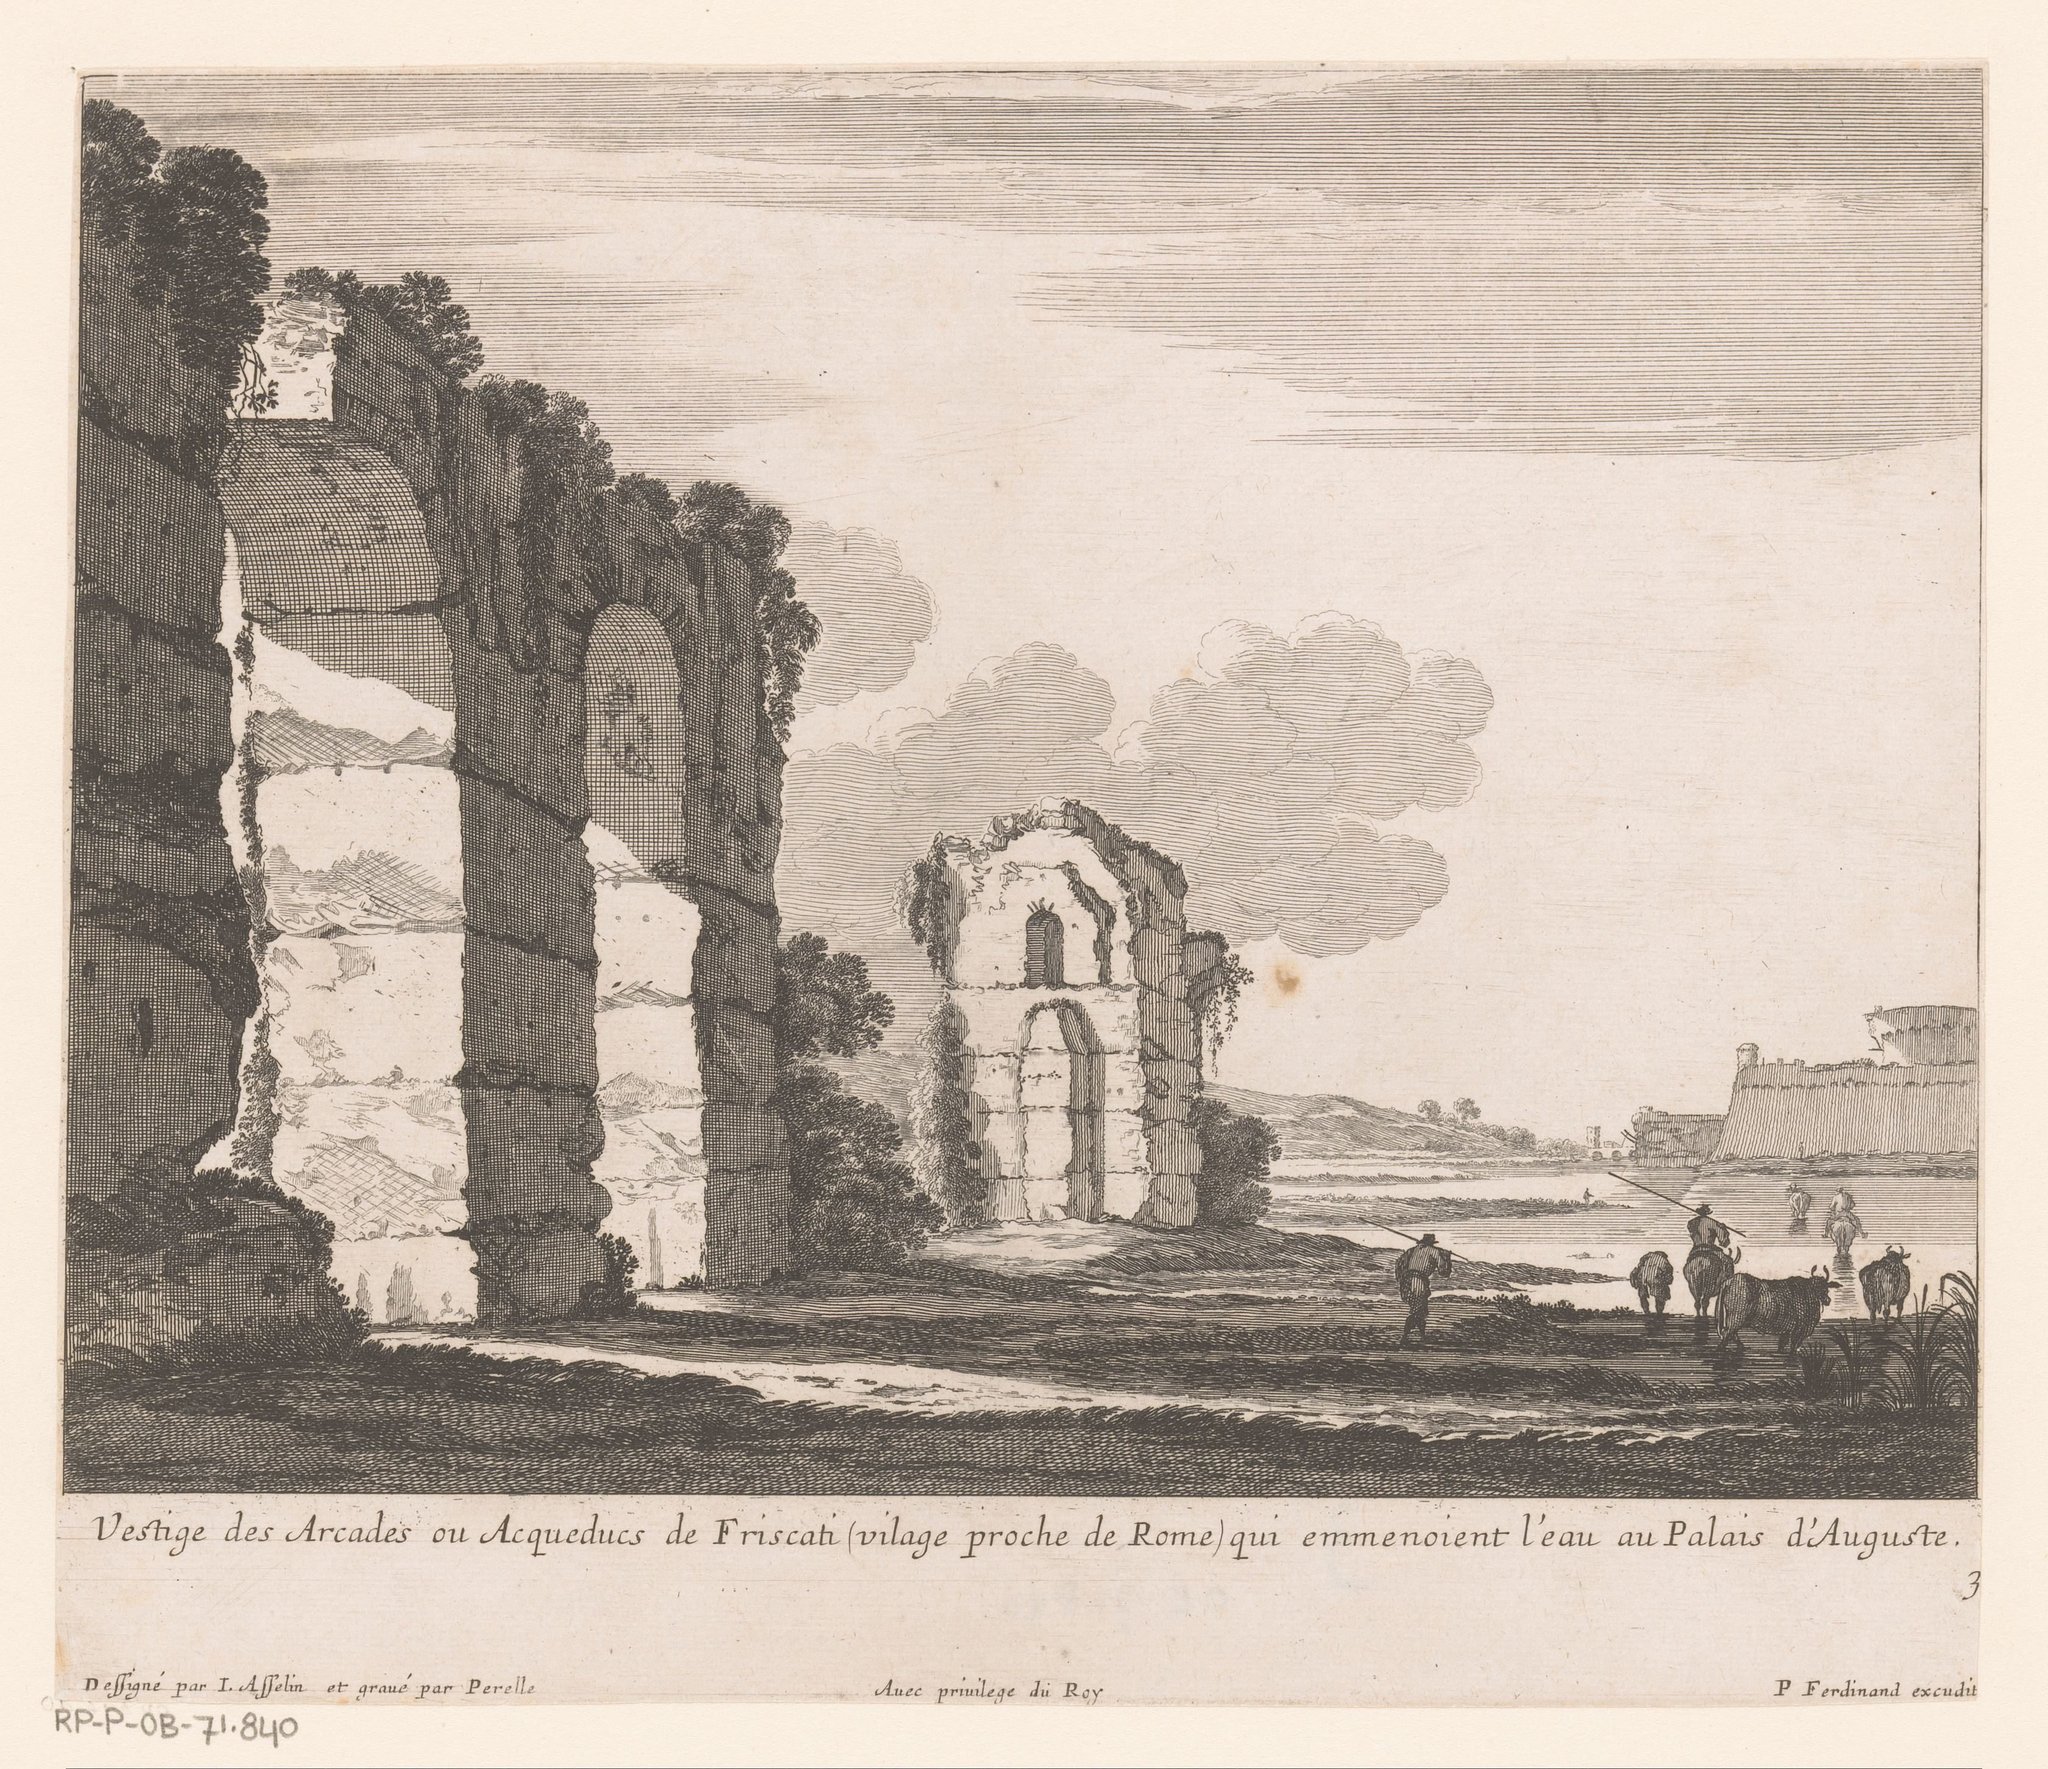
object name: print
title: Landschap met ruïnes en koeherders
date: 1627-1655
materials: paper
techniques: engraving, etching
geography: france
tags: landscape with ruins (+ city(-scape) with figures, staffage), herd, flock, rome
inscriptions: collector's mark: Lugt 240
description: Prenten met het signatuur 'Perelle' kunnen zowel door vader Gabriel als door zonen Nicolas en Adam gemaakt zijn.